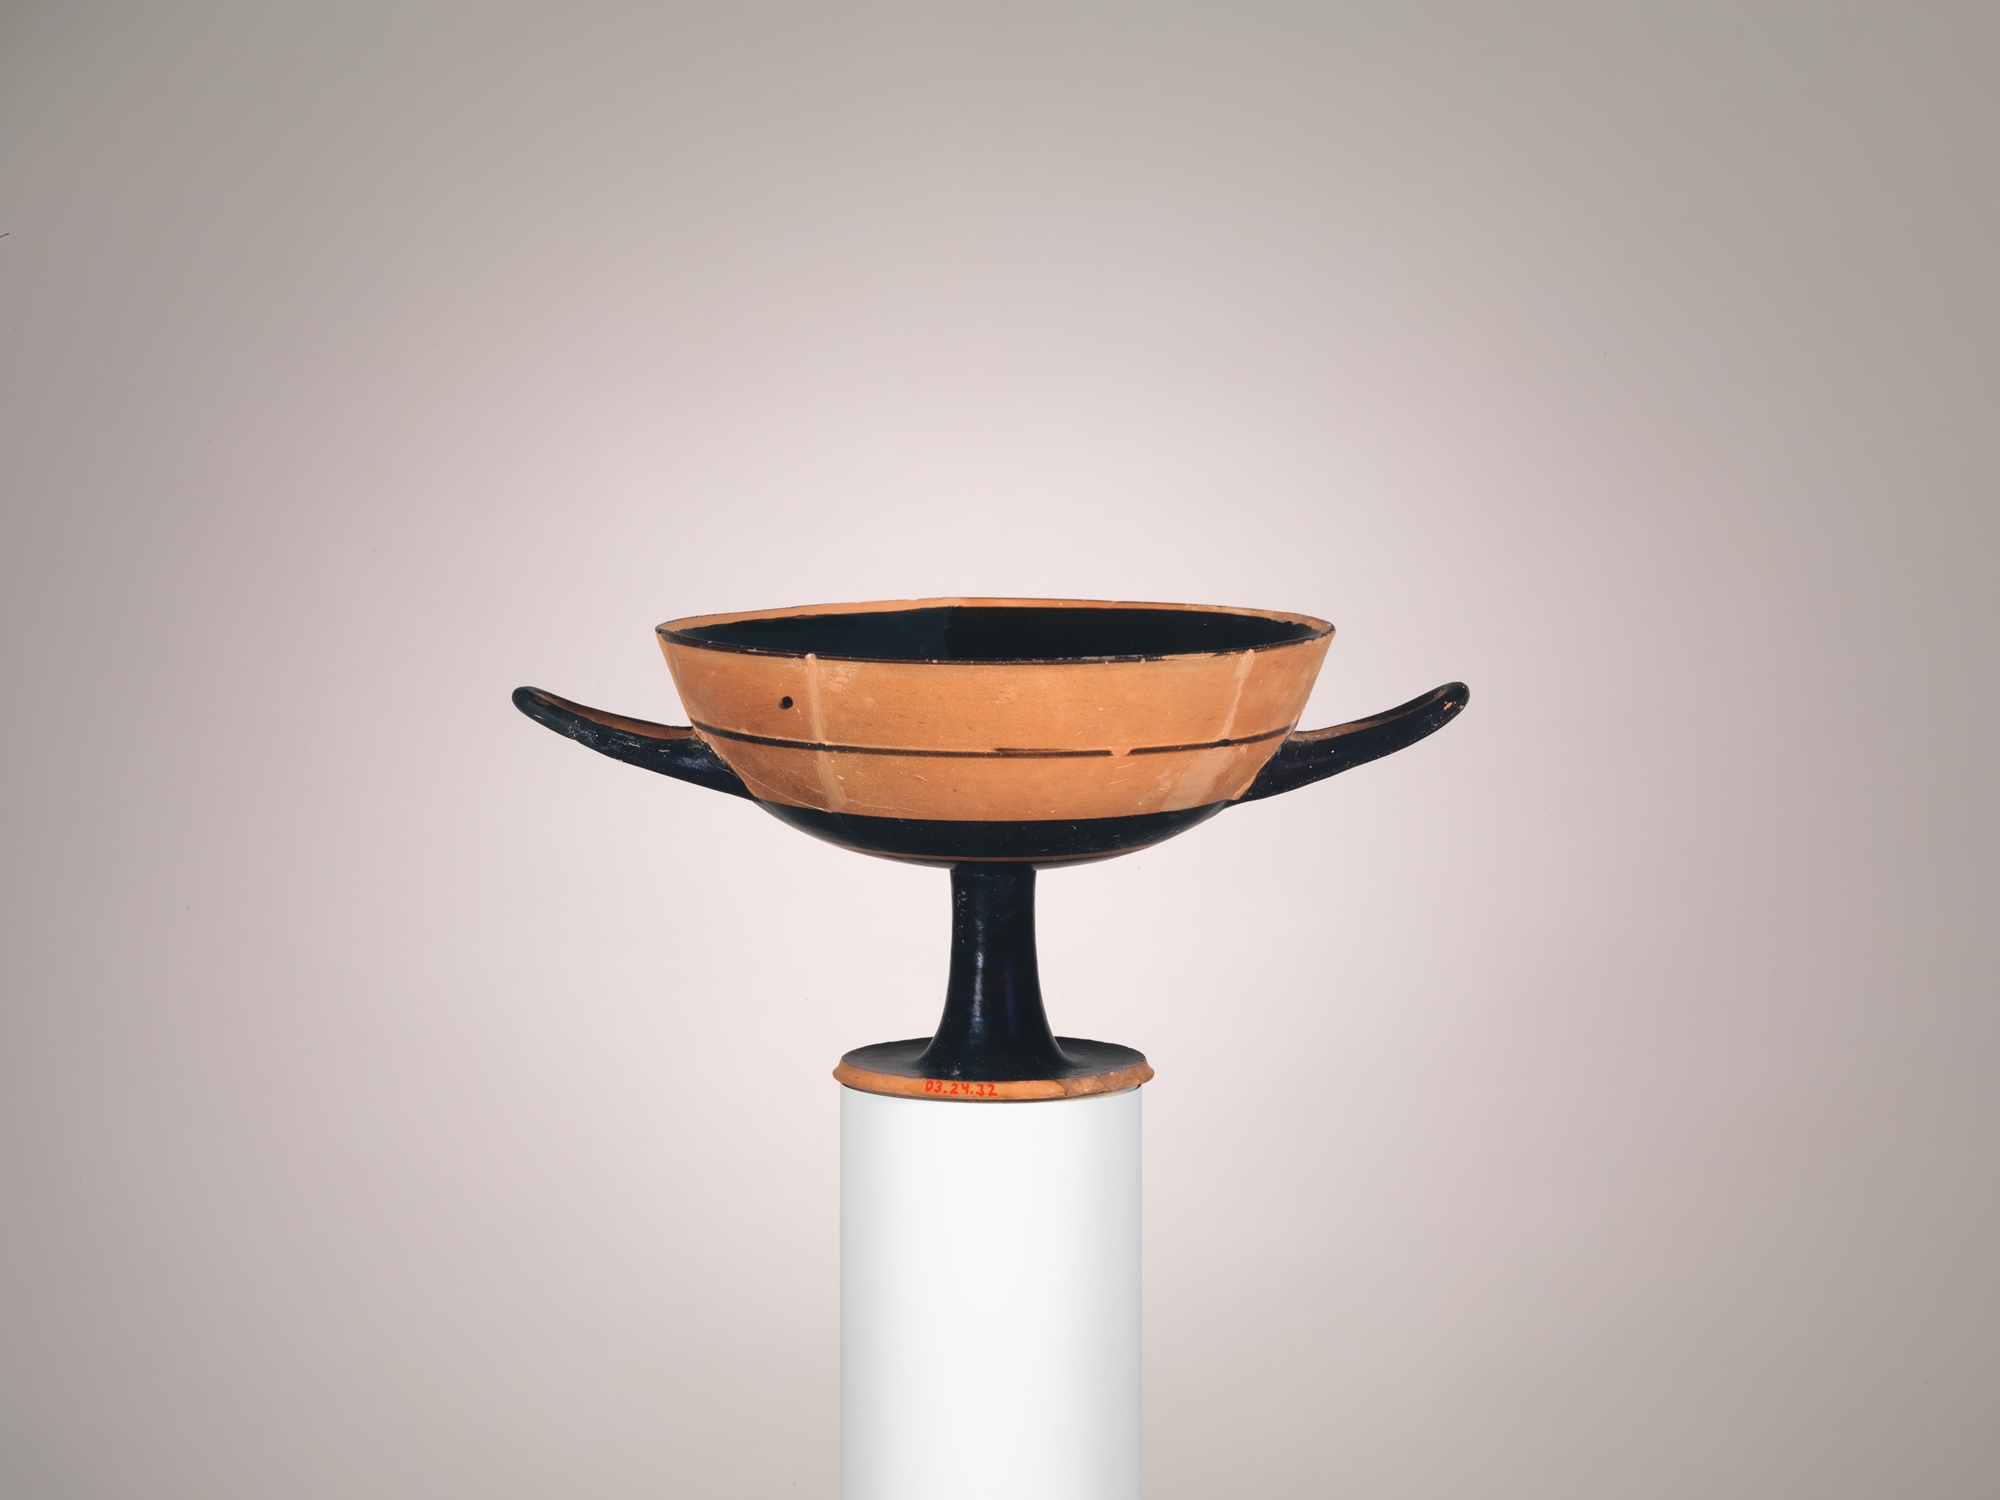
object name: kylix, lip cup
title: Terracotta Little Master cup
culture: greek, attic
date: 550-525 BCE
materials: terracotta